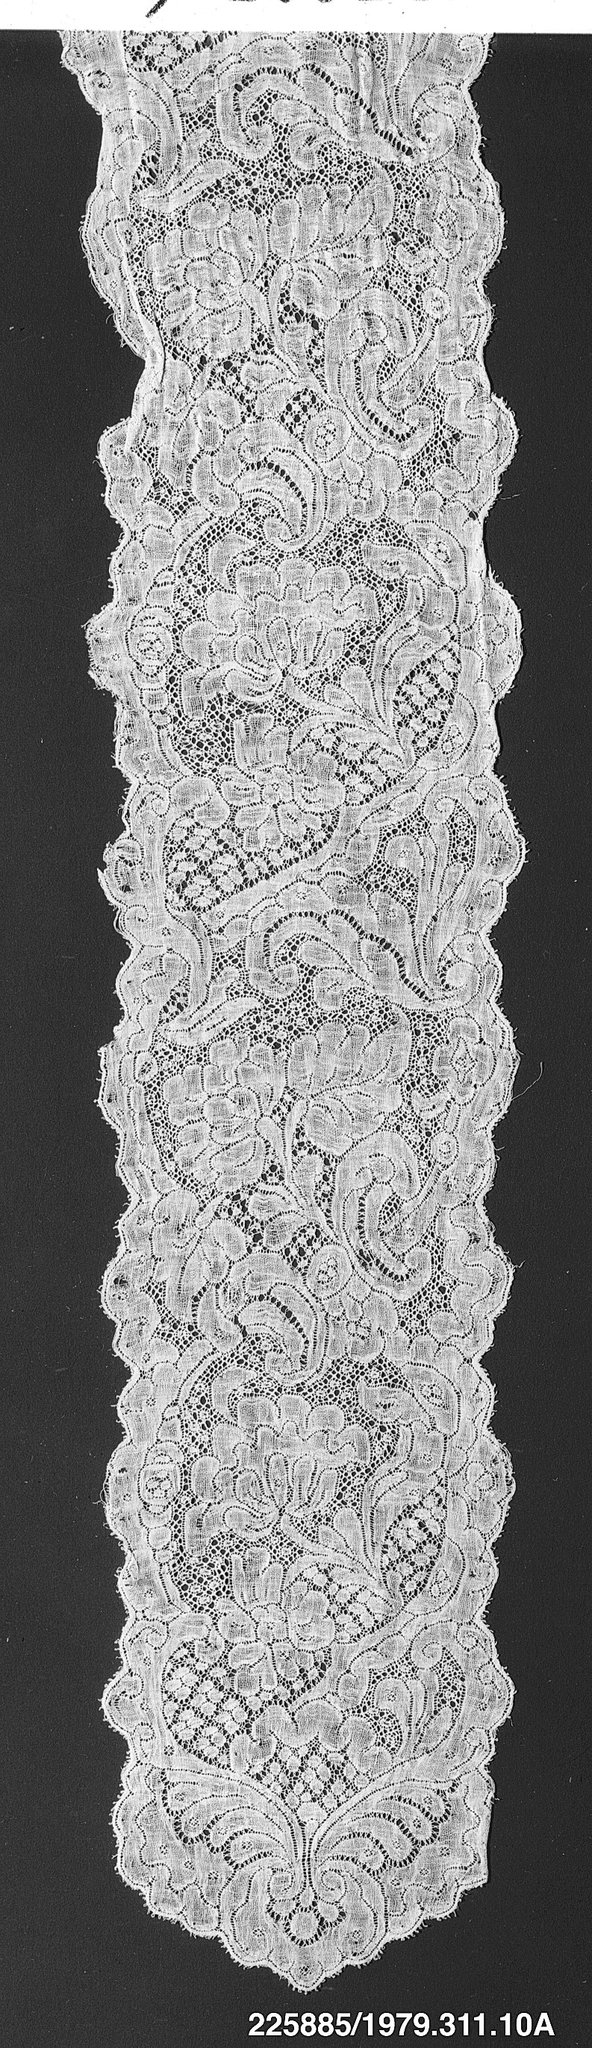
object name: lappet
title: Lappets (2)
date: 1667-1700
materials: linen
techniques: lace